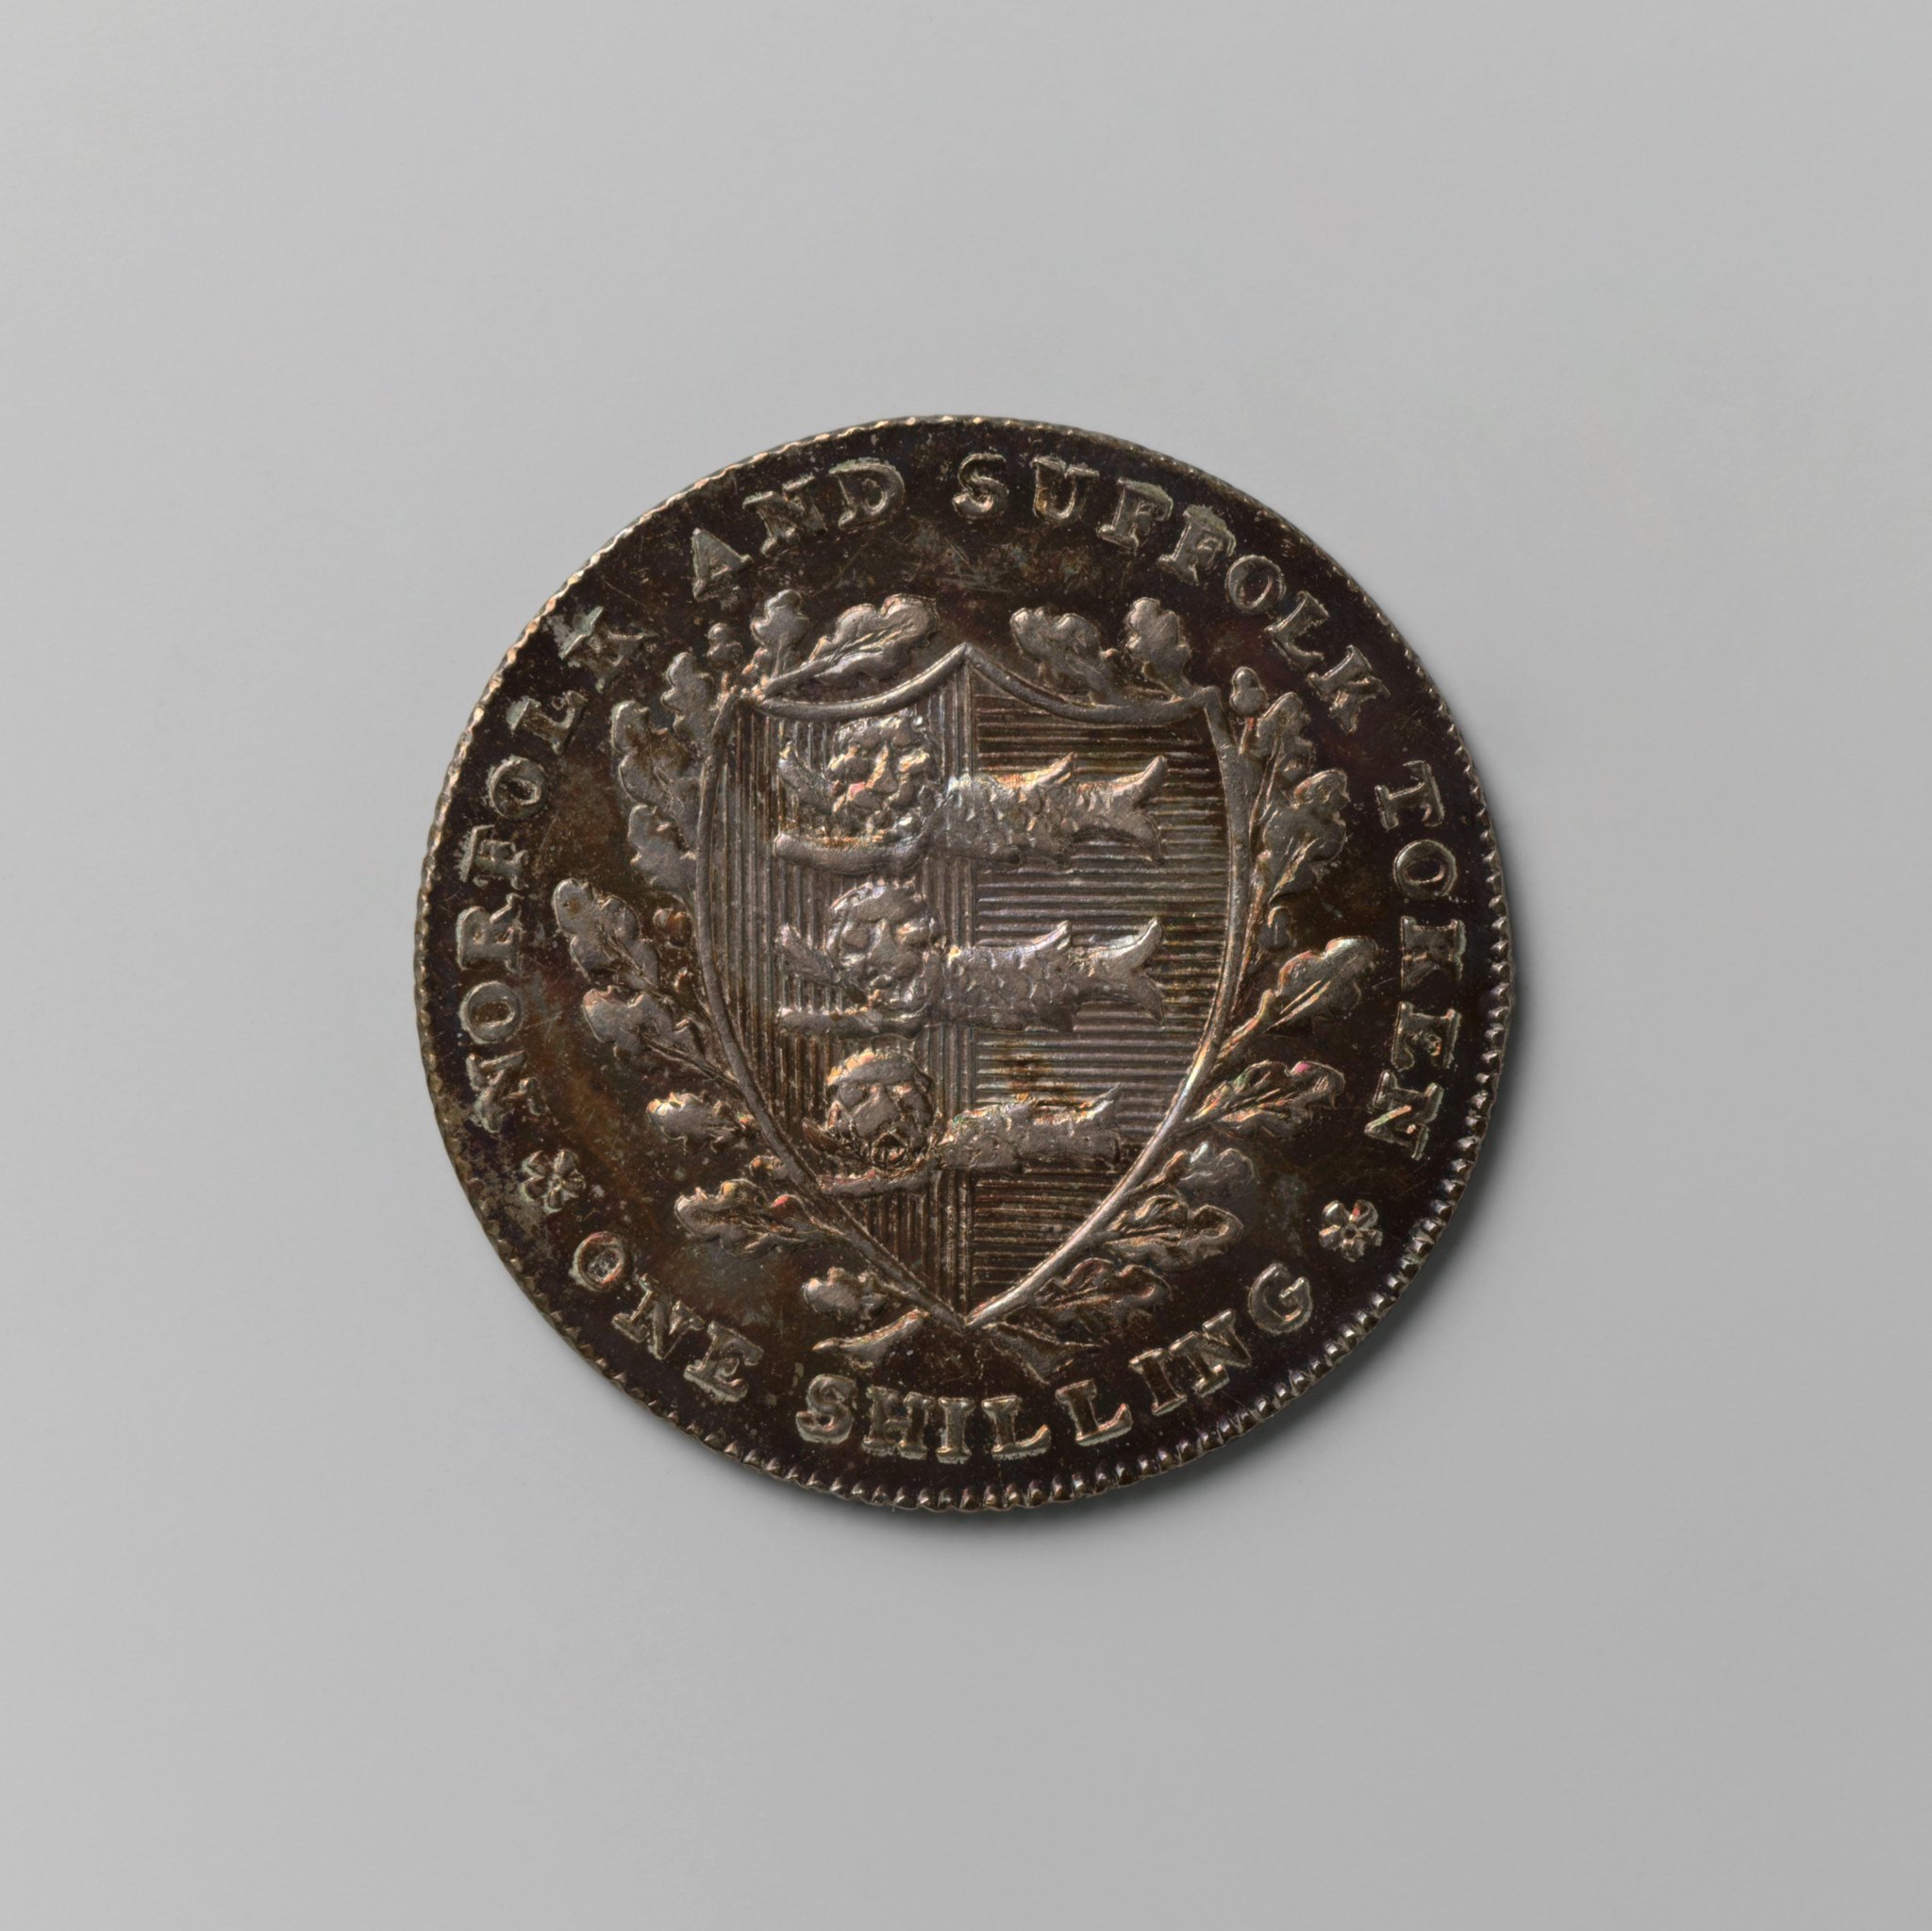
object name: monetary token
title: Shilling-token, Yarmouth, Engeland, 1811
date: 1811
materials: silver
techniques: striking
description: Zilveren particuliere munt. Voorzijde: tussen gekruiste palm- en lauriertak wapenschild. Daaronder jaartal. Keerzijde: tussen gekruiste eiketakken wapenschild. Daaronder waarde-aanduiding in omschrift. Kabelrand.